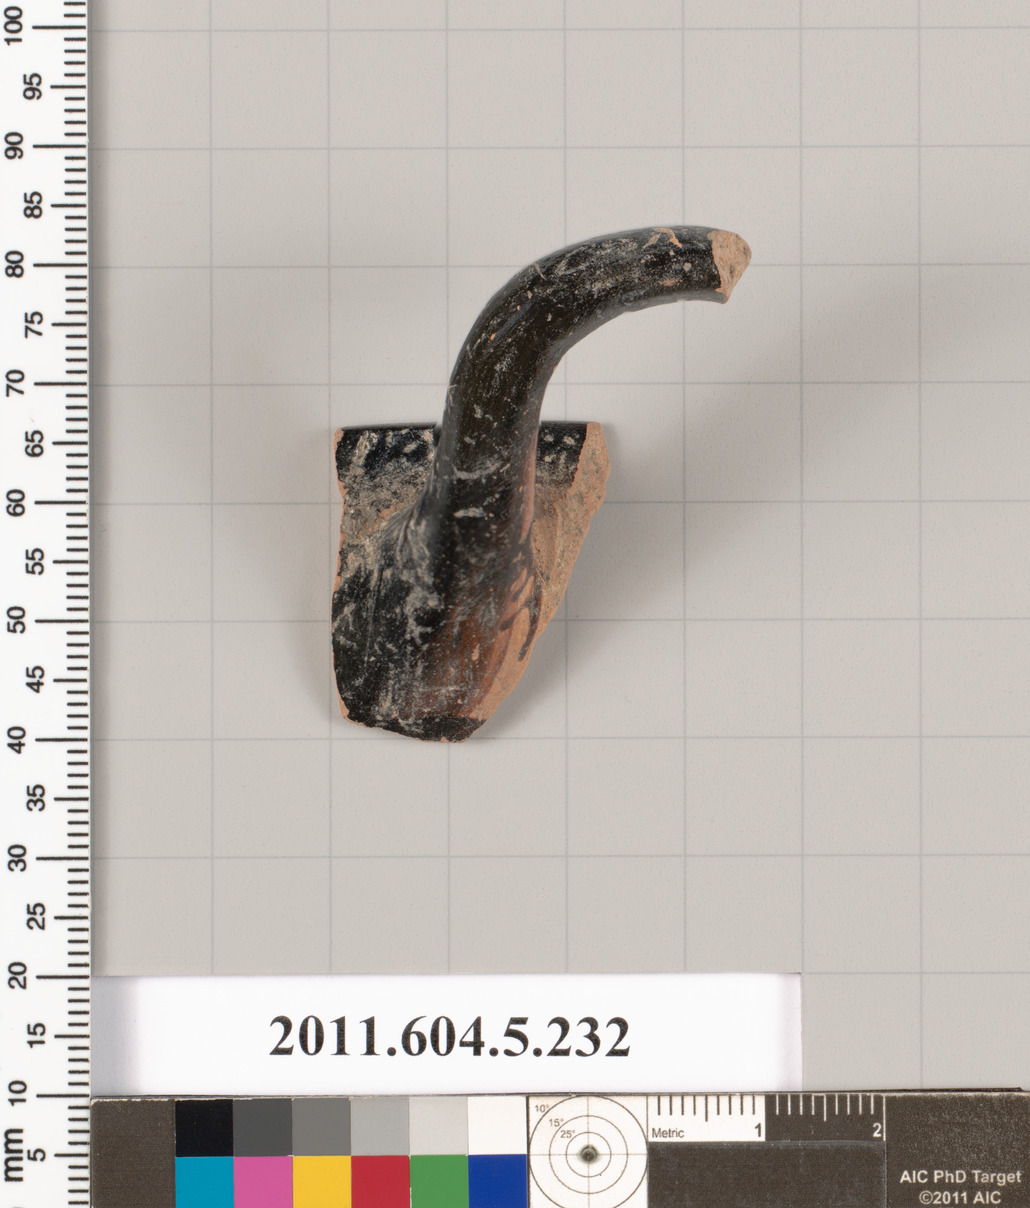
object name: kylix fragment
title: Terracotta rim fragment of a kylix (drinking cup)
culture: greek, attic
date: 600-401 BCE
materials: terracotta